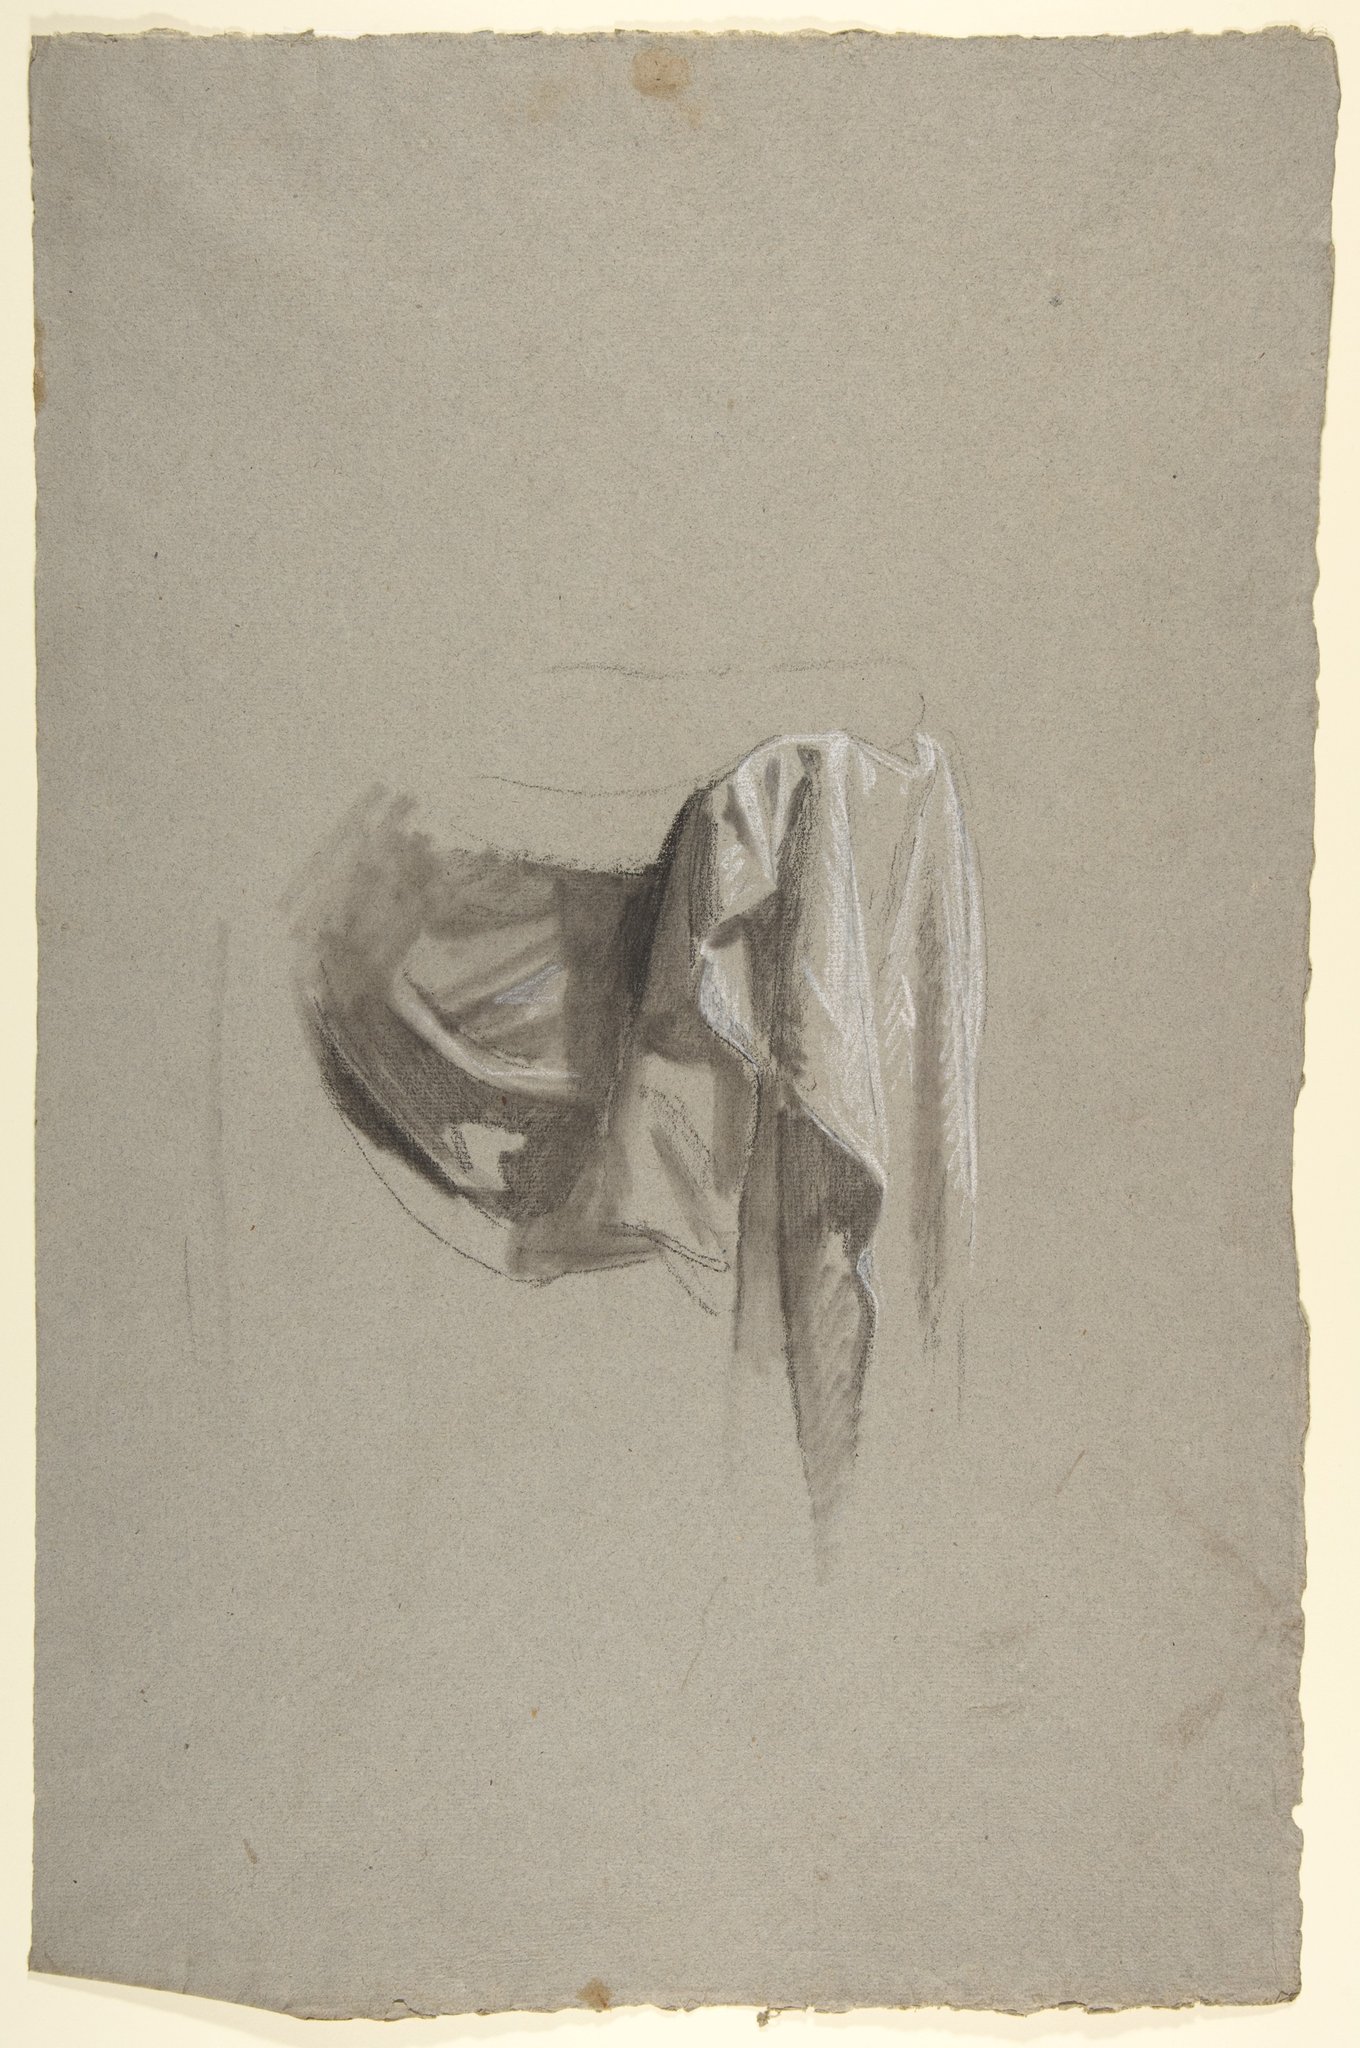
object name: drawing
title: Drapery Study for Figure Holding Crown (middle register); study for wall paintings in the Chapel of Saint Remi, Sainte-Clotilde, Paris, 1858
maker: isidore pils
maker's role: artist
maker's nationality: french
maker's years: 1813-1875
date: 1801-1900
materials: chalk, paper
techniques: heightening, stumping